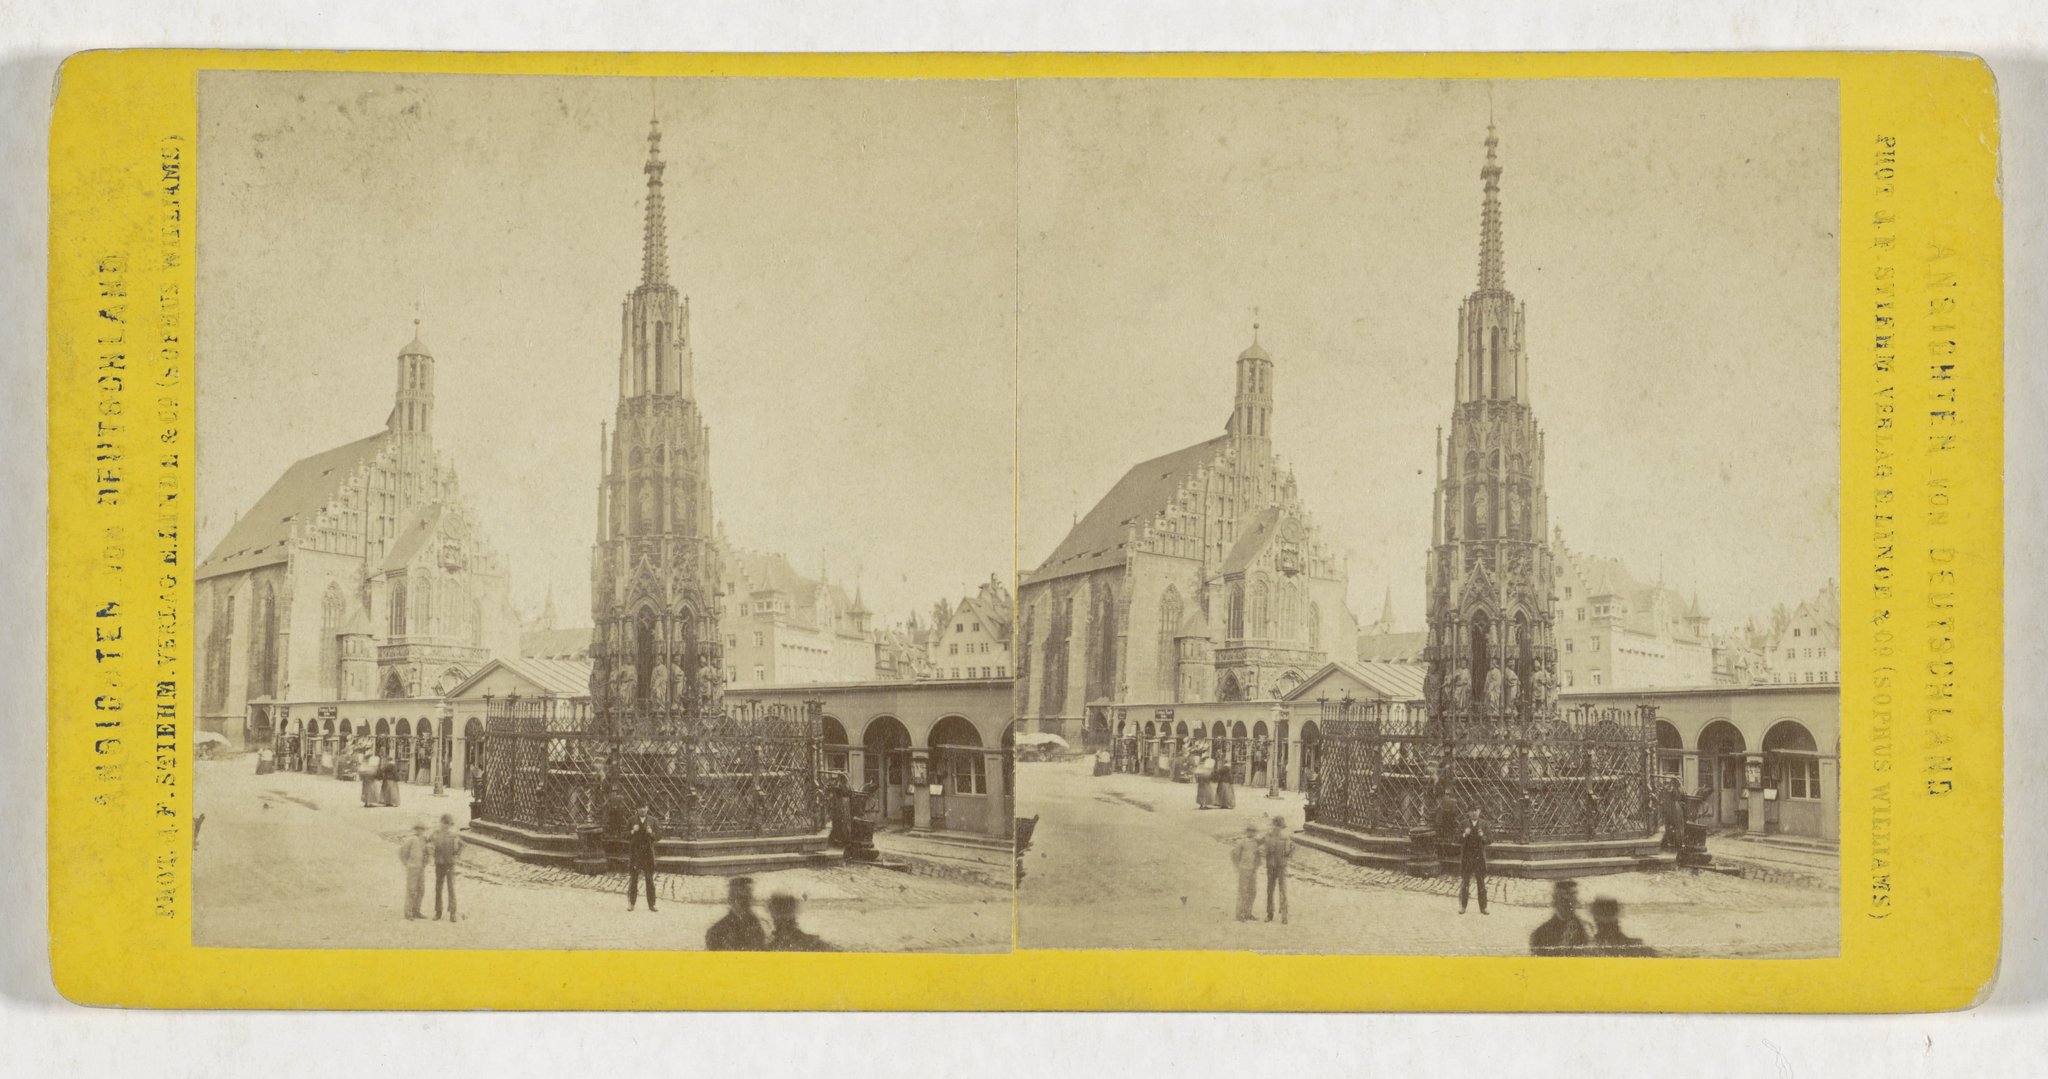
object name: stereograph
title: Schönerbrunnen und Frauenkirche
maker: johann friedrich stiehm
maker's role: fotograaf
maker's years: 1826-1902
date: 1868-1888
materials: cardboard, paper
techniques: albumen print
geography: nuremberg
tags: square, place, circus, etc., church (exterior), ornamental fountain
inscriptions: number: ‘No. 12.’